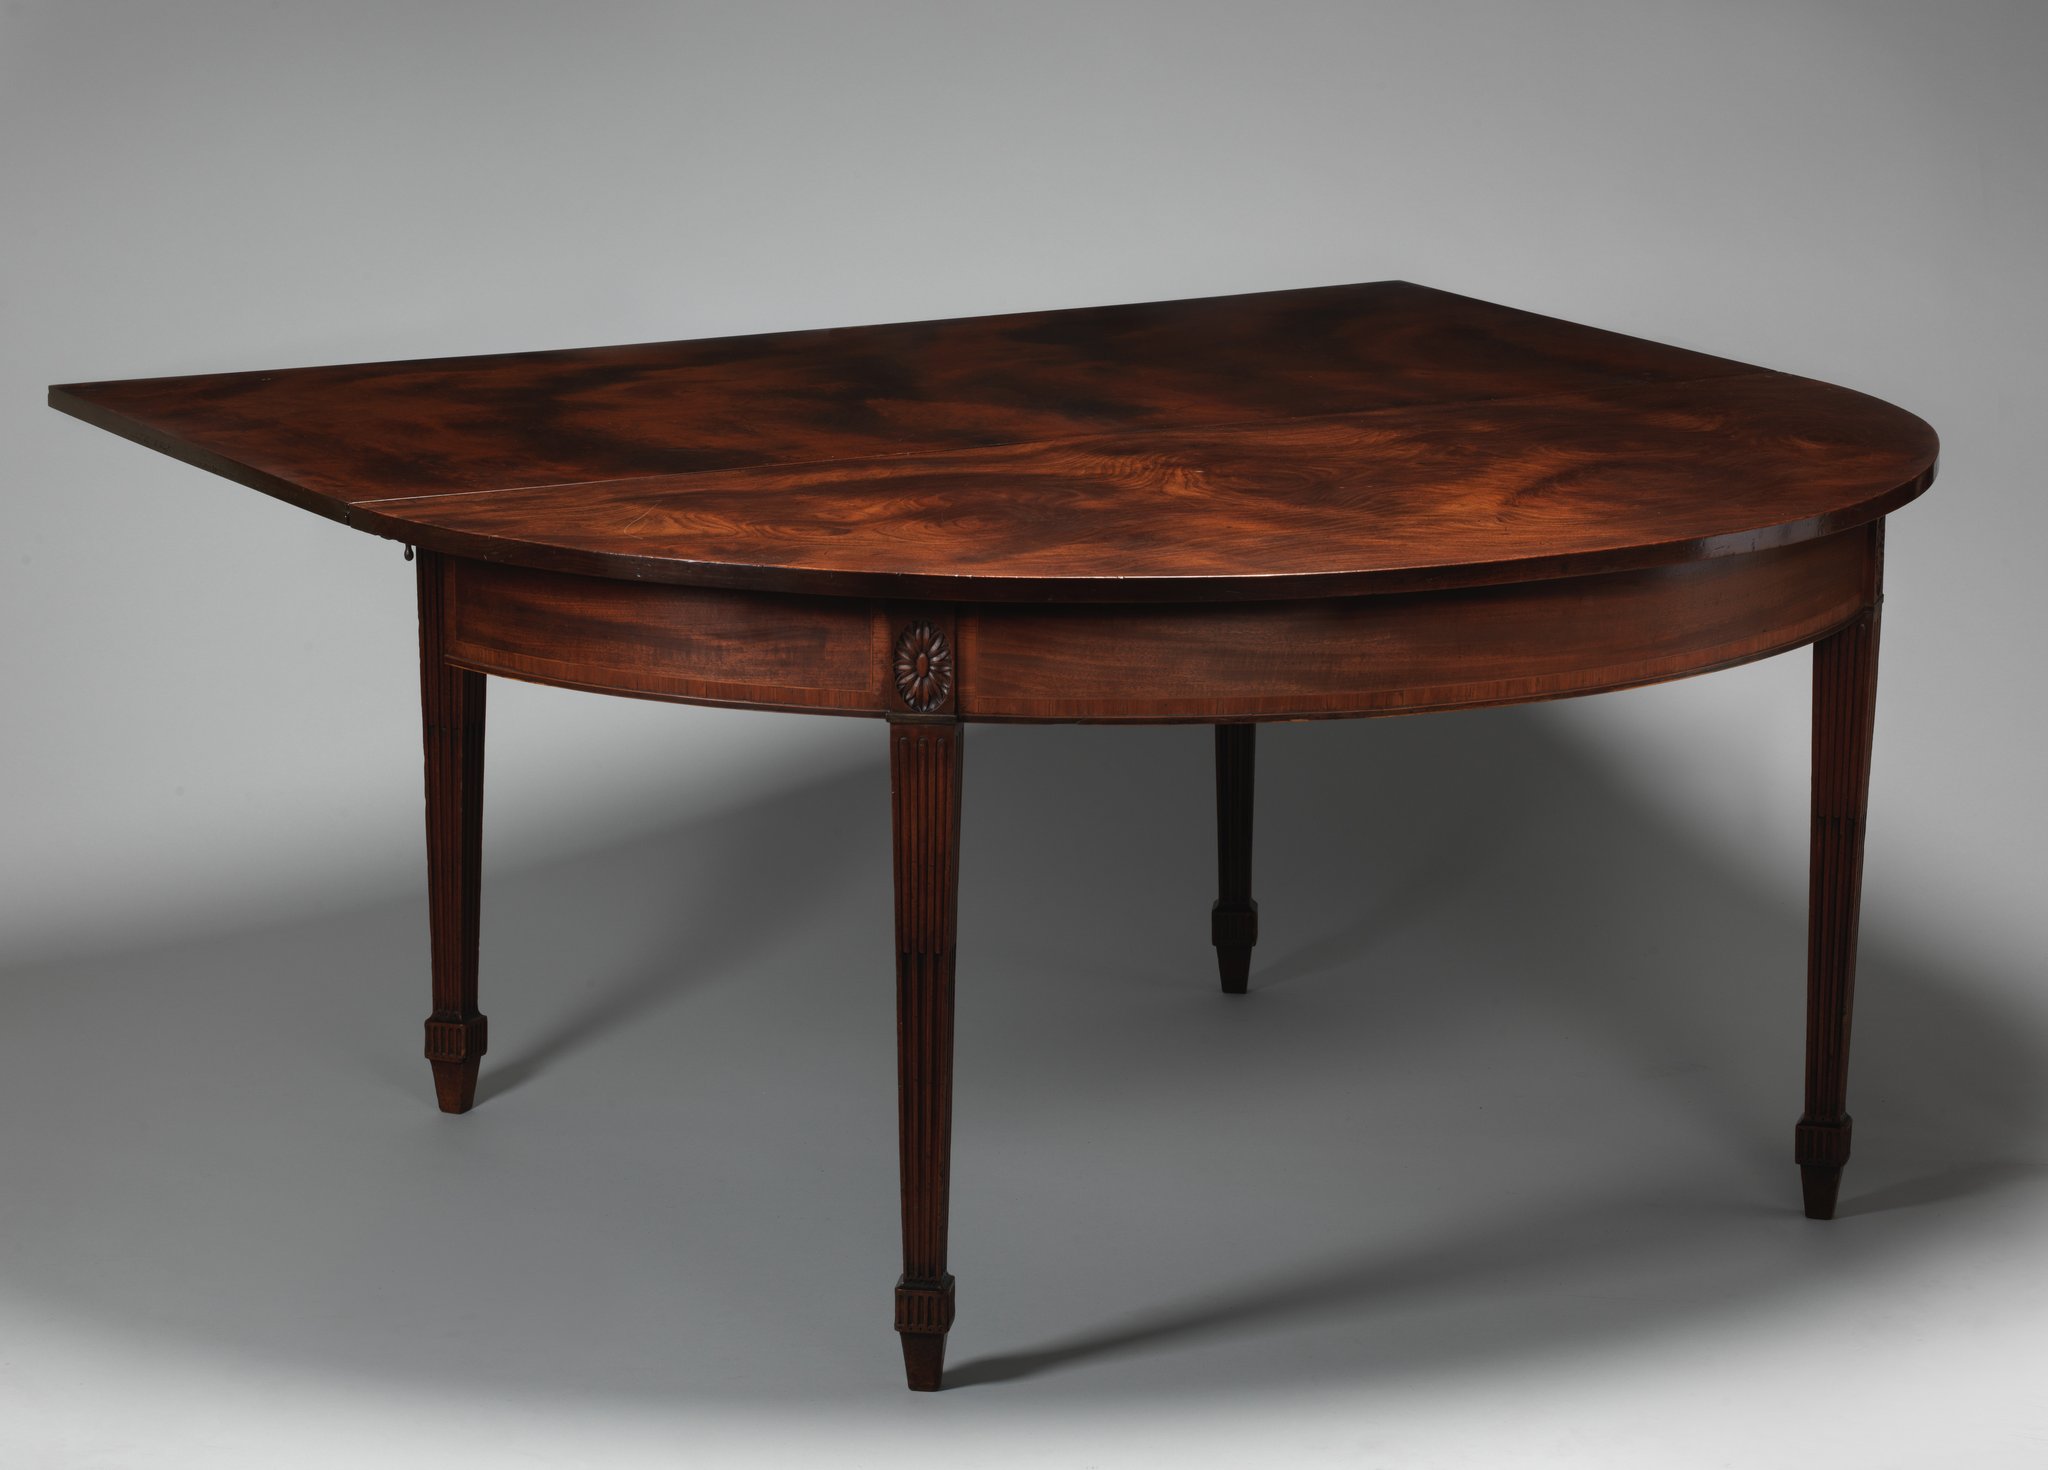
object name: dining table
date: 1770-1780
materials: wood